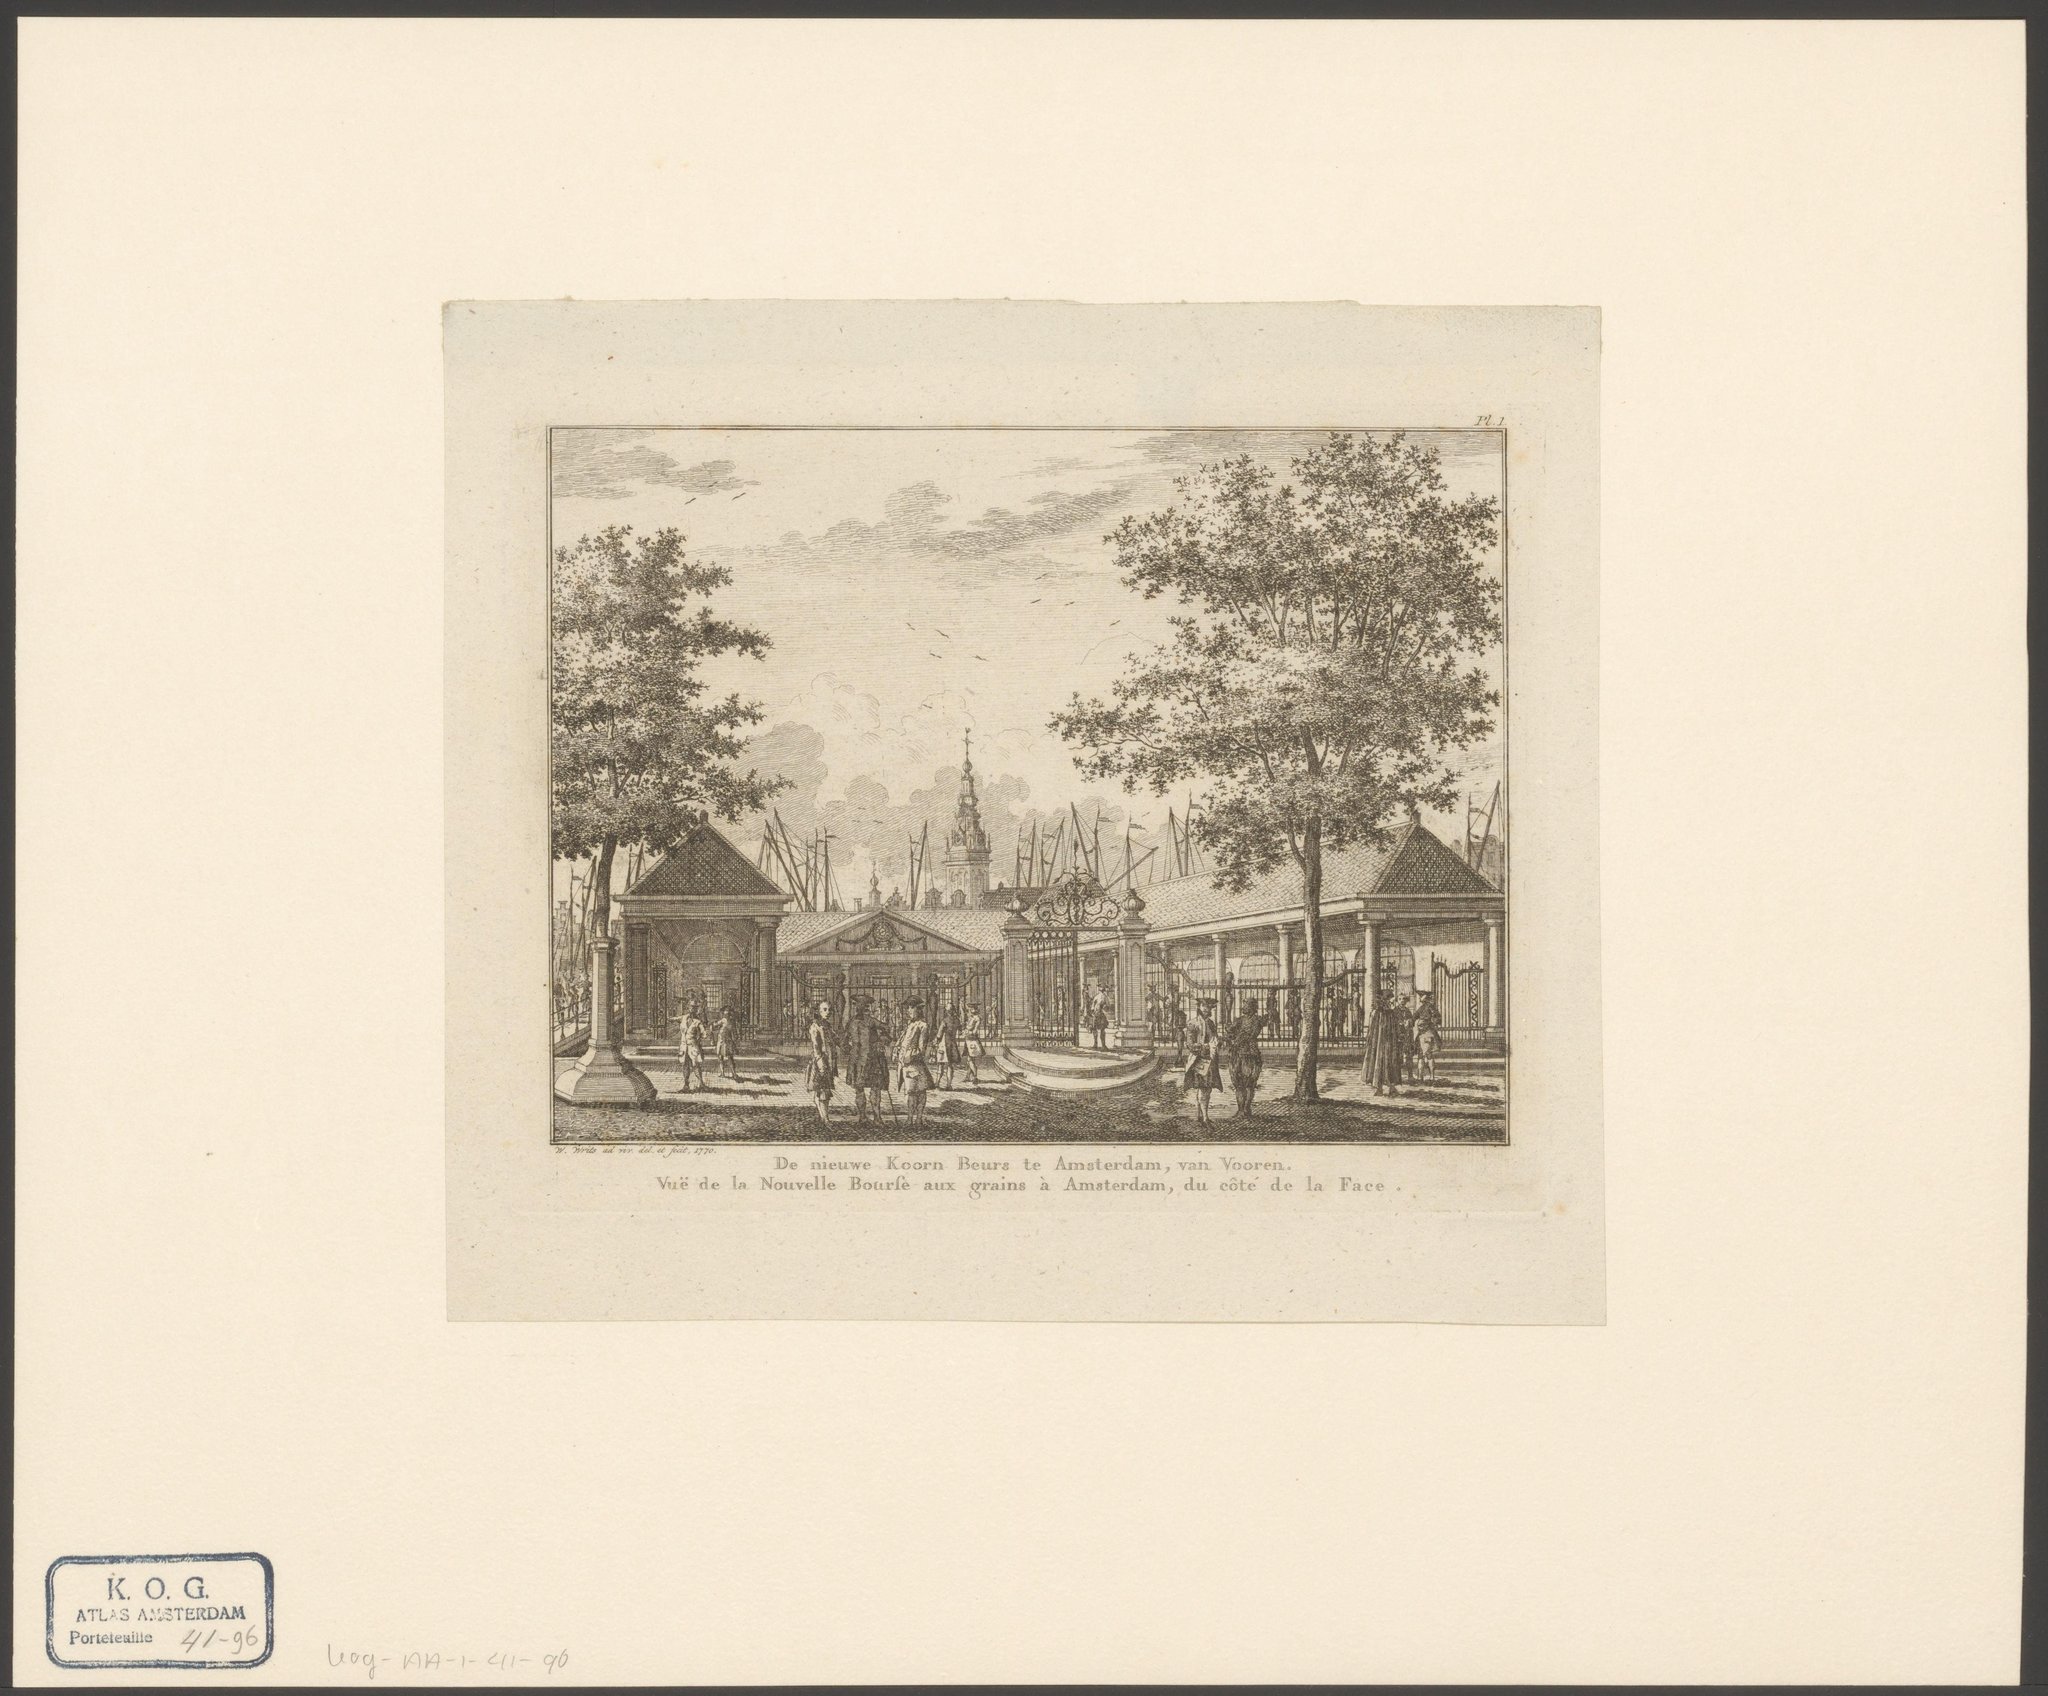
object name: book illustration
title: De nieuwe Koorn Beurs te Amsterdam, van Vooren / Vuë de la Nouvelle Bourse aux grains à Amsterdam, du côté de la Face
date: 1770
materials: paper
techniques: engraving, etching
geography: amsterdam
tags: sailing-ship, sailing-boat, market-hall, parts of church exterior and annexes: tower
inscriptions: collector's mark: ‘41-96’ Lugt 1641b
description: Prent uit: Atlas, of verzameling van afbeeldingen der voornaamste gebouwen, torens en gezichten der stad Amsterdam, voor kinderen. Amsterdam: H. Moolenijzer, 1824, dl. 1, pl. 1. Eerdere staat van prent verscheen in: Elwe, Jan Barend. Atlas van de wereldberoemde koopstad Amsteldam (...). Amsterdam: Jan Barend Elwe, 1804. Mogelijk bestaat er een nog eerdere plaat gezien de datering op het object zelf (1770).